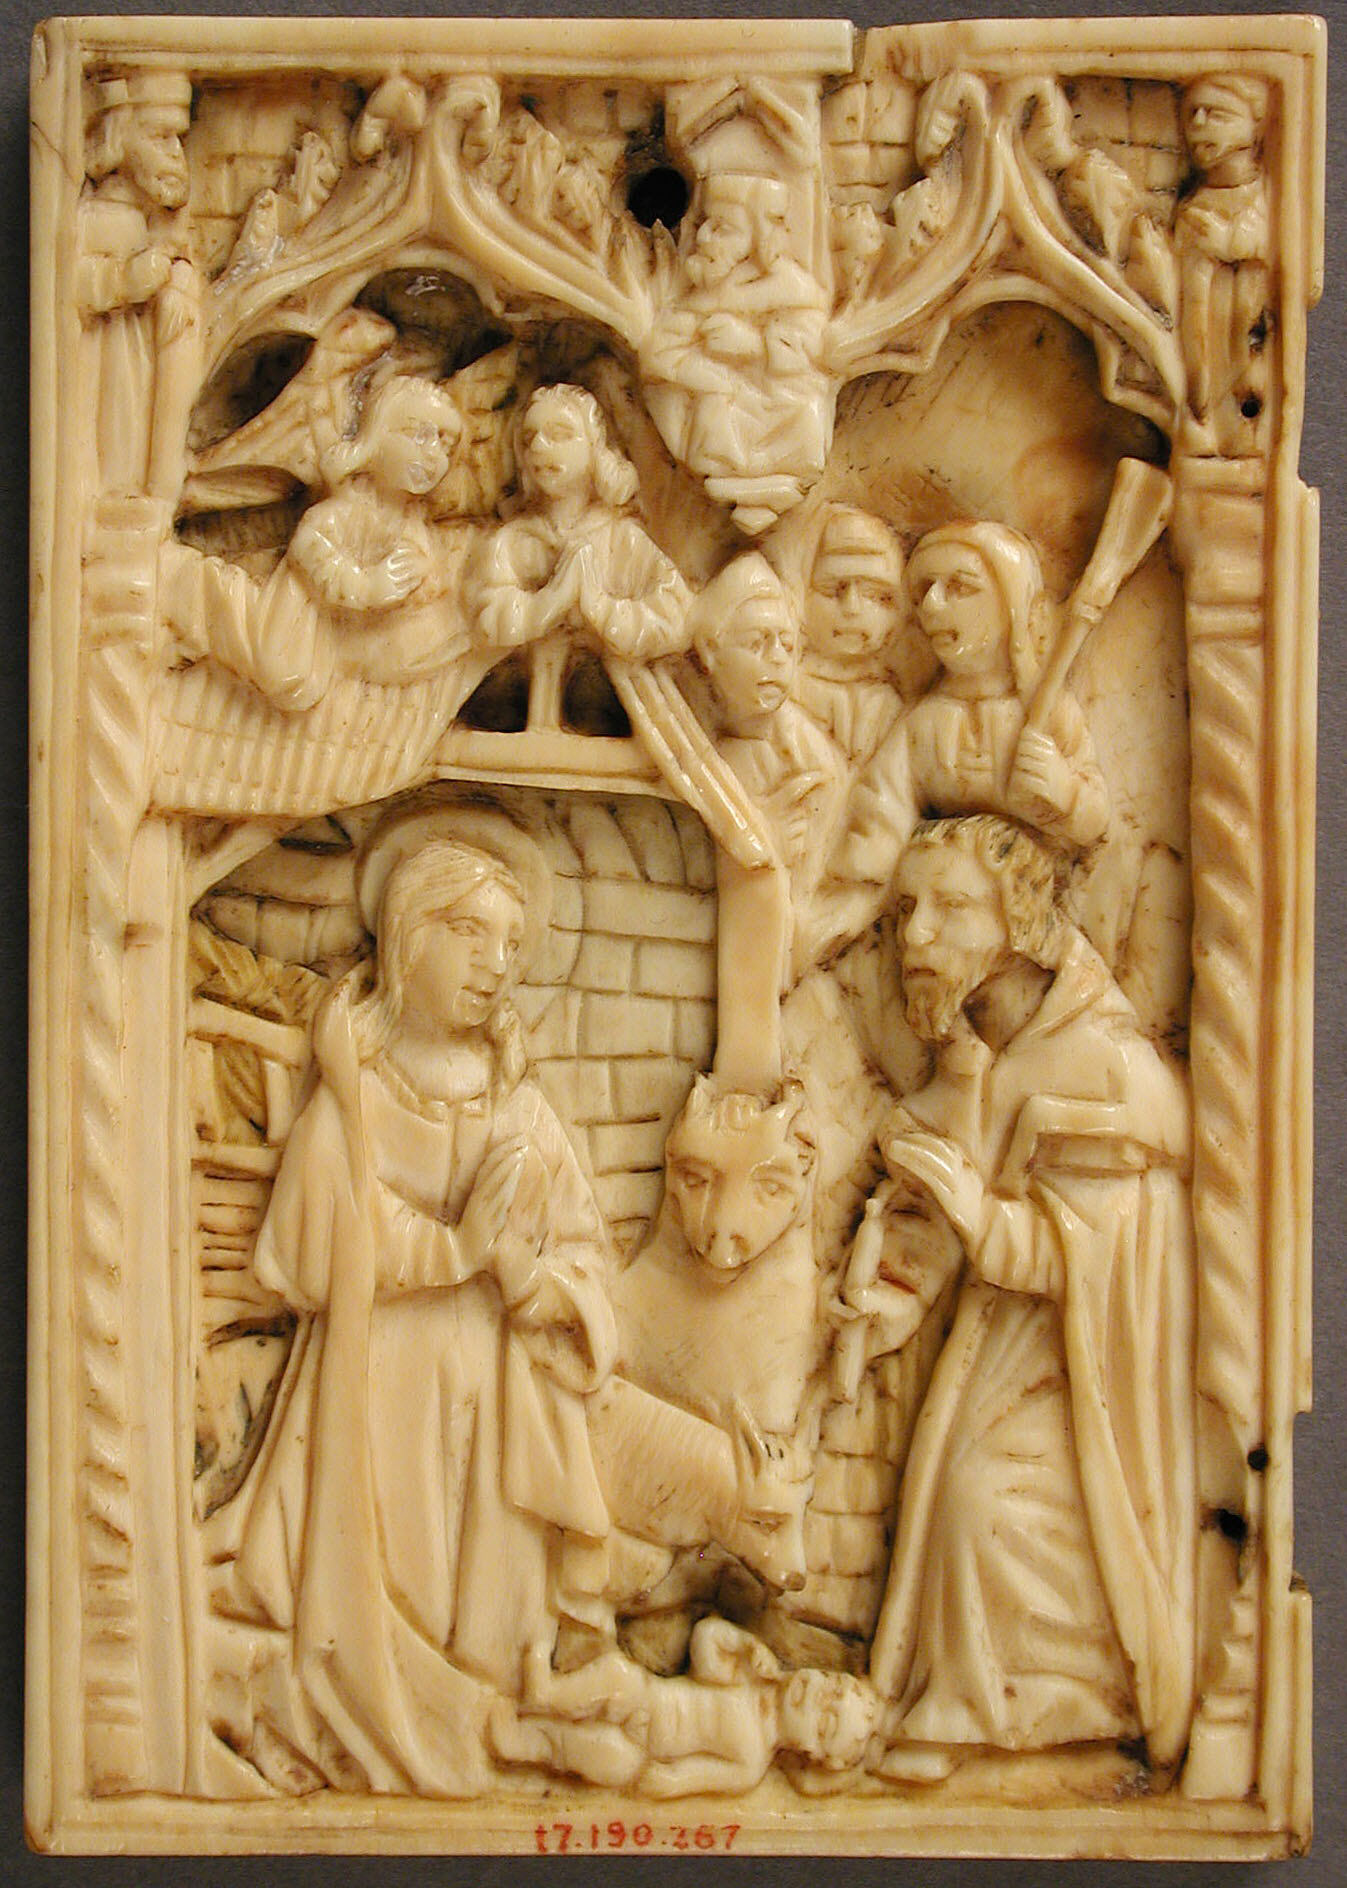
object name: diptych wing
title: Left Wing of a Diptych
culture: franco-netherlandish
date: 1401-1500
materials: ivory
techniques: polychromy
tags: animals,men,women,angels